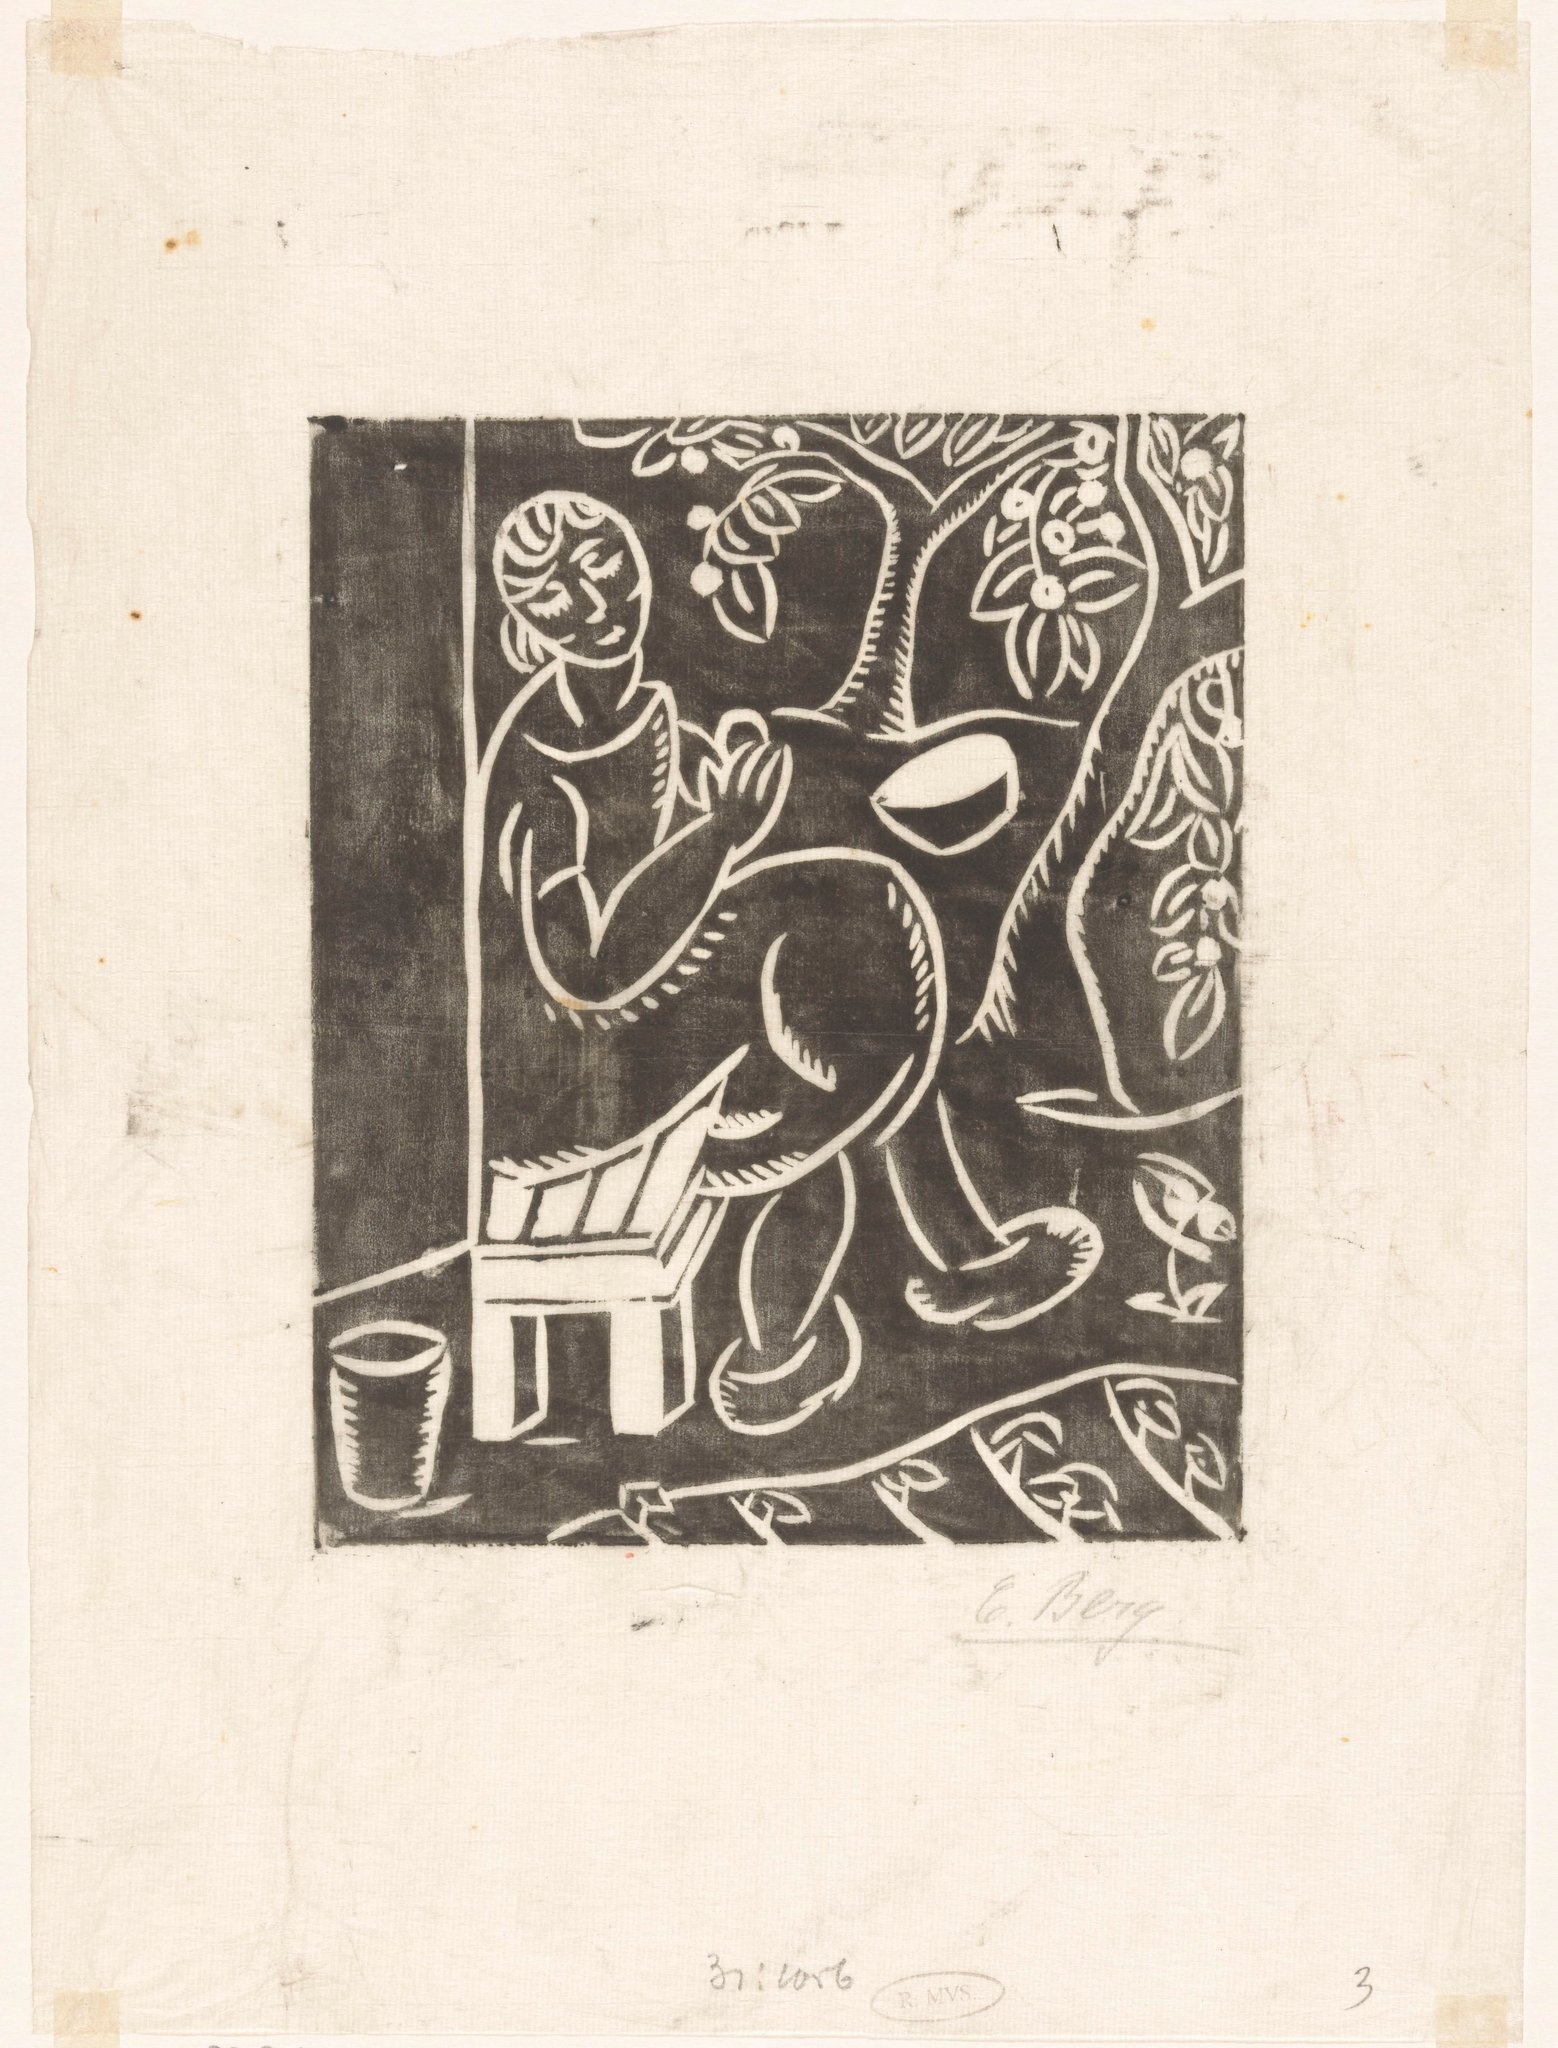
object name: print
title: Vrouw op bank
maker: else berg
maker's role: designer, draughtsman, painter, print maker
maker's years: 1877-1942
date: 1912-1931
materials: paper, ink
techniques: woodcut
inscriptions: number: ‘3’, collector's mark: Lugt 2228, signature: ‘E. Berg’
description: Vrouw zittend op een bank bij twee bomen met vruchten.